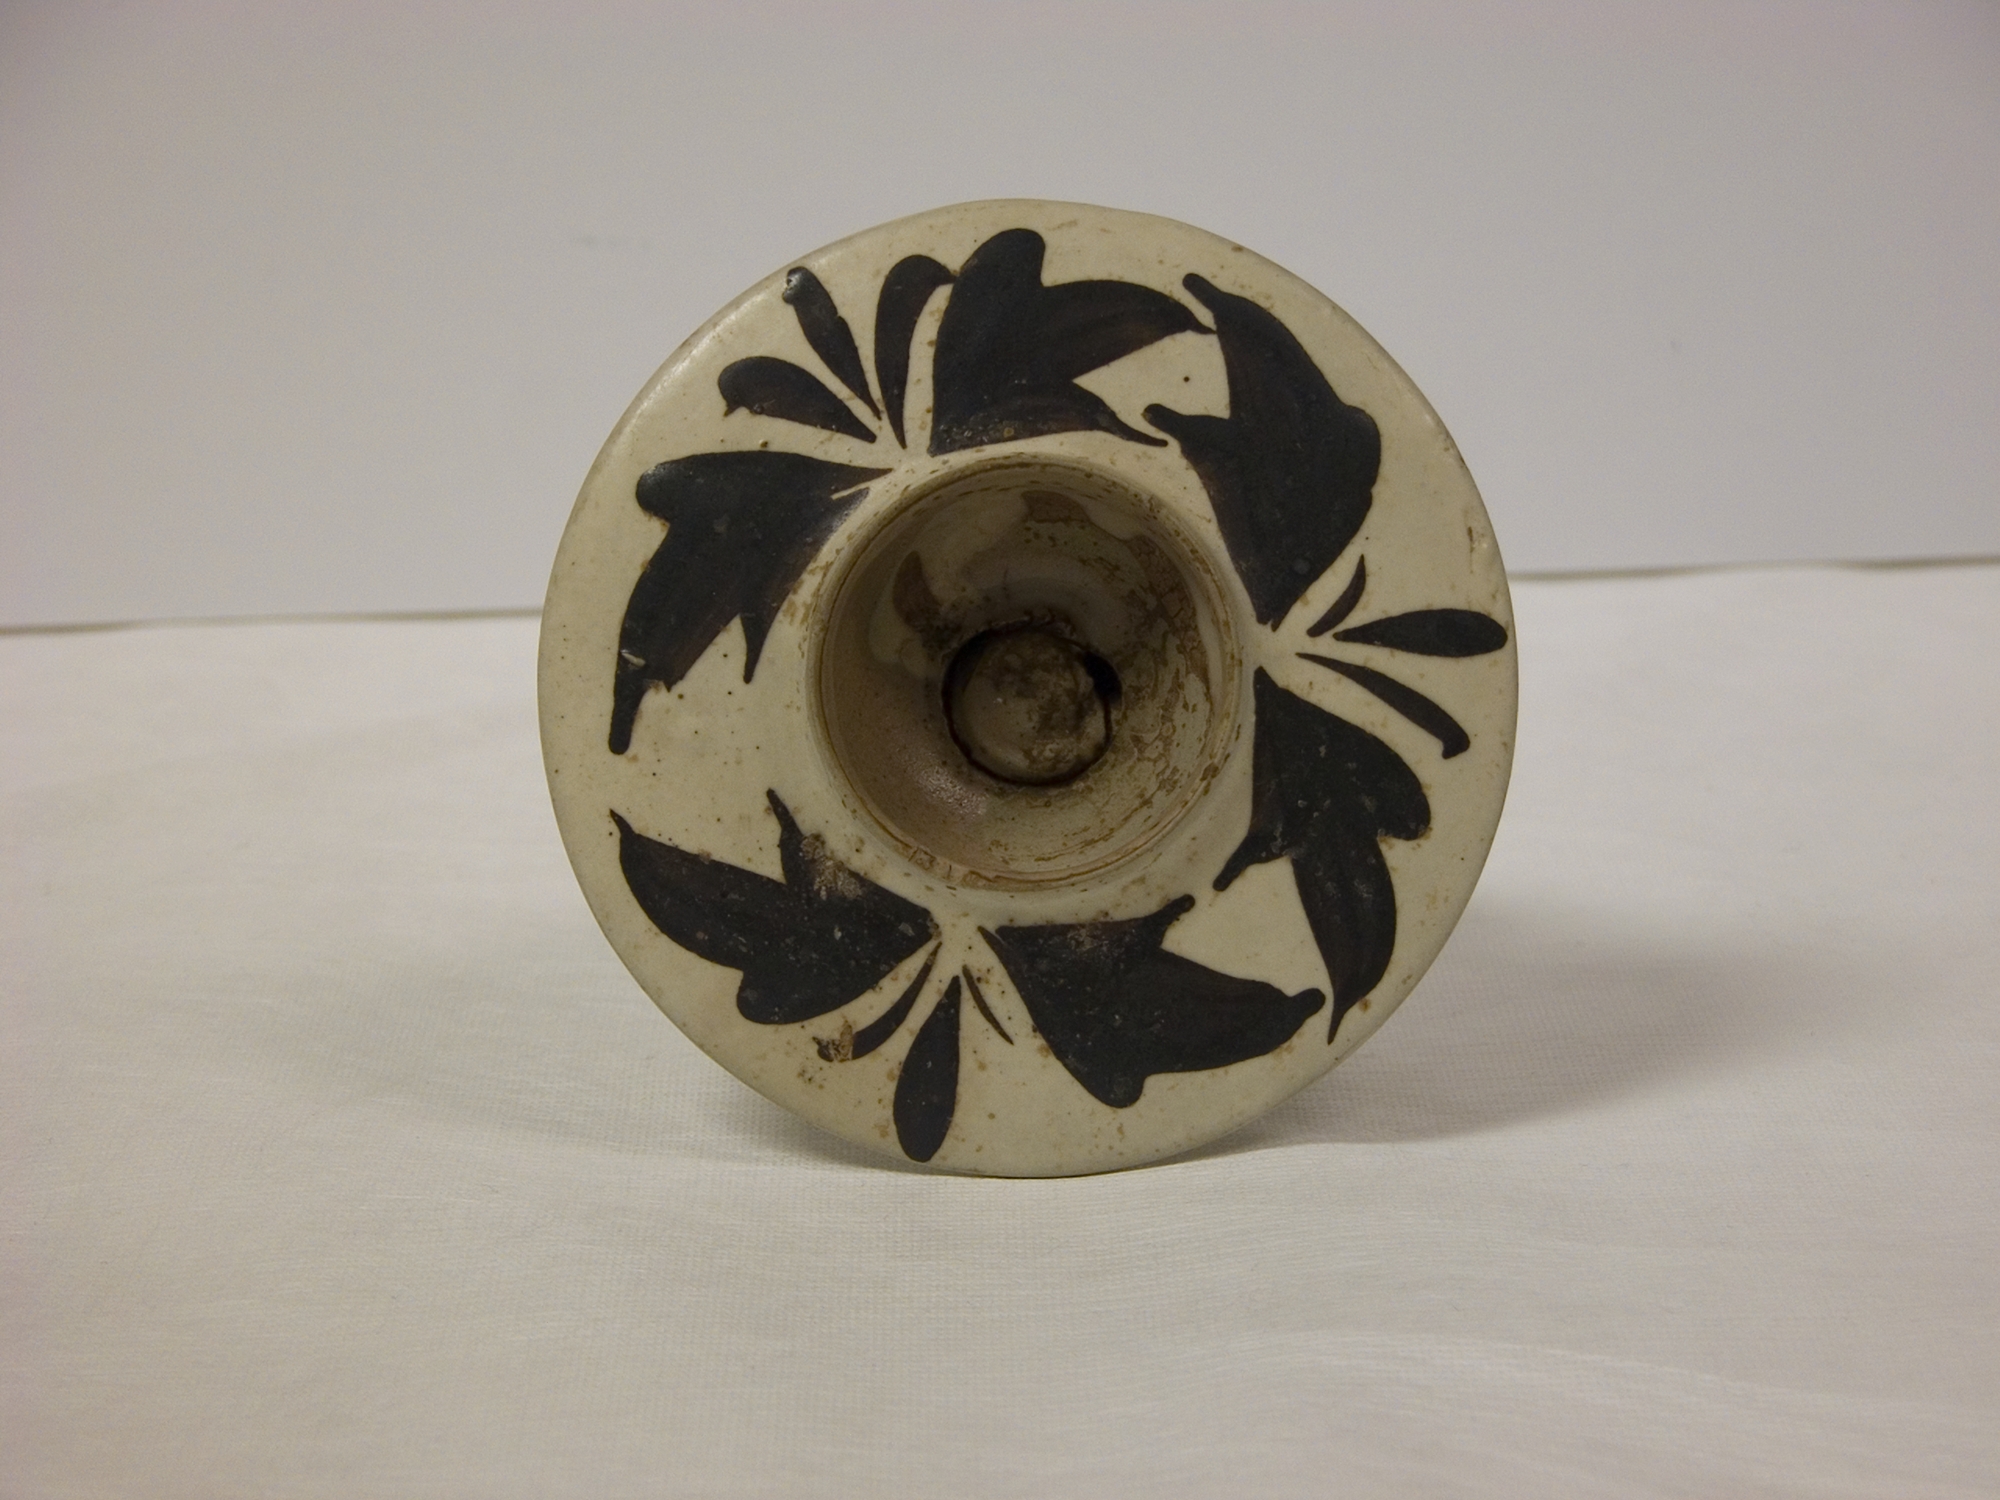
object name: cup stand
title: Cup-stand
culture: chinese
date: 960-1279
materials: pottery